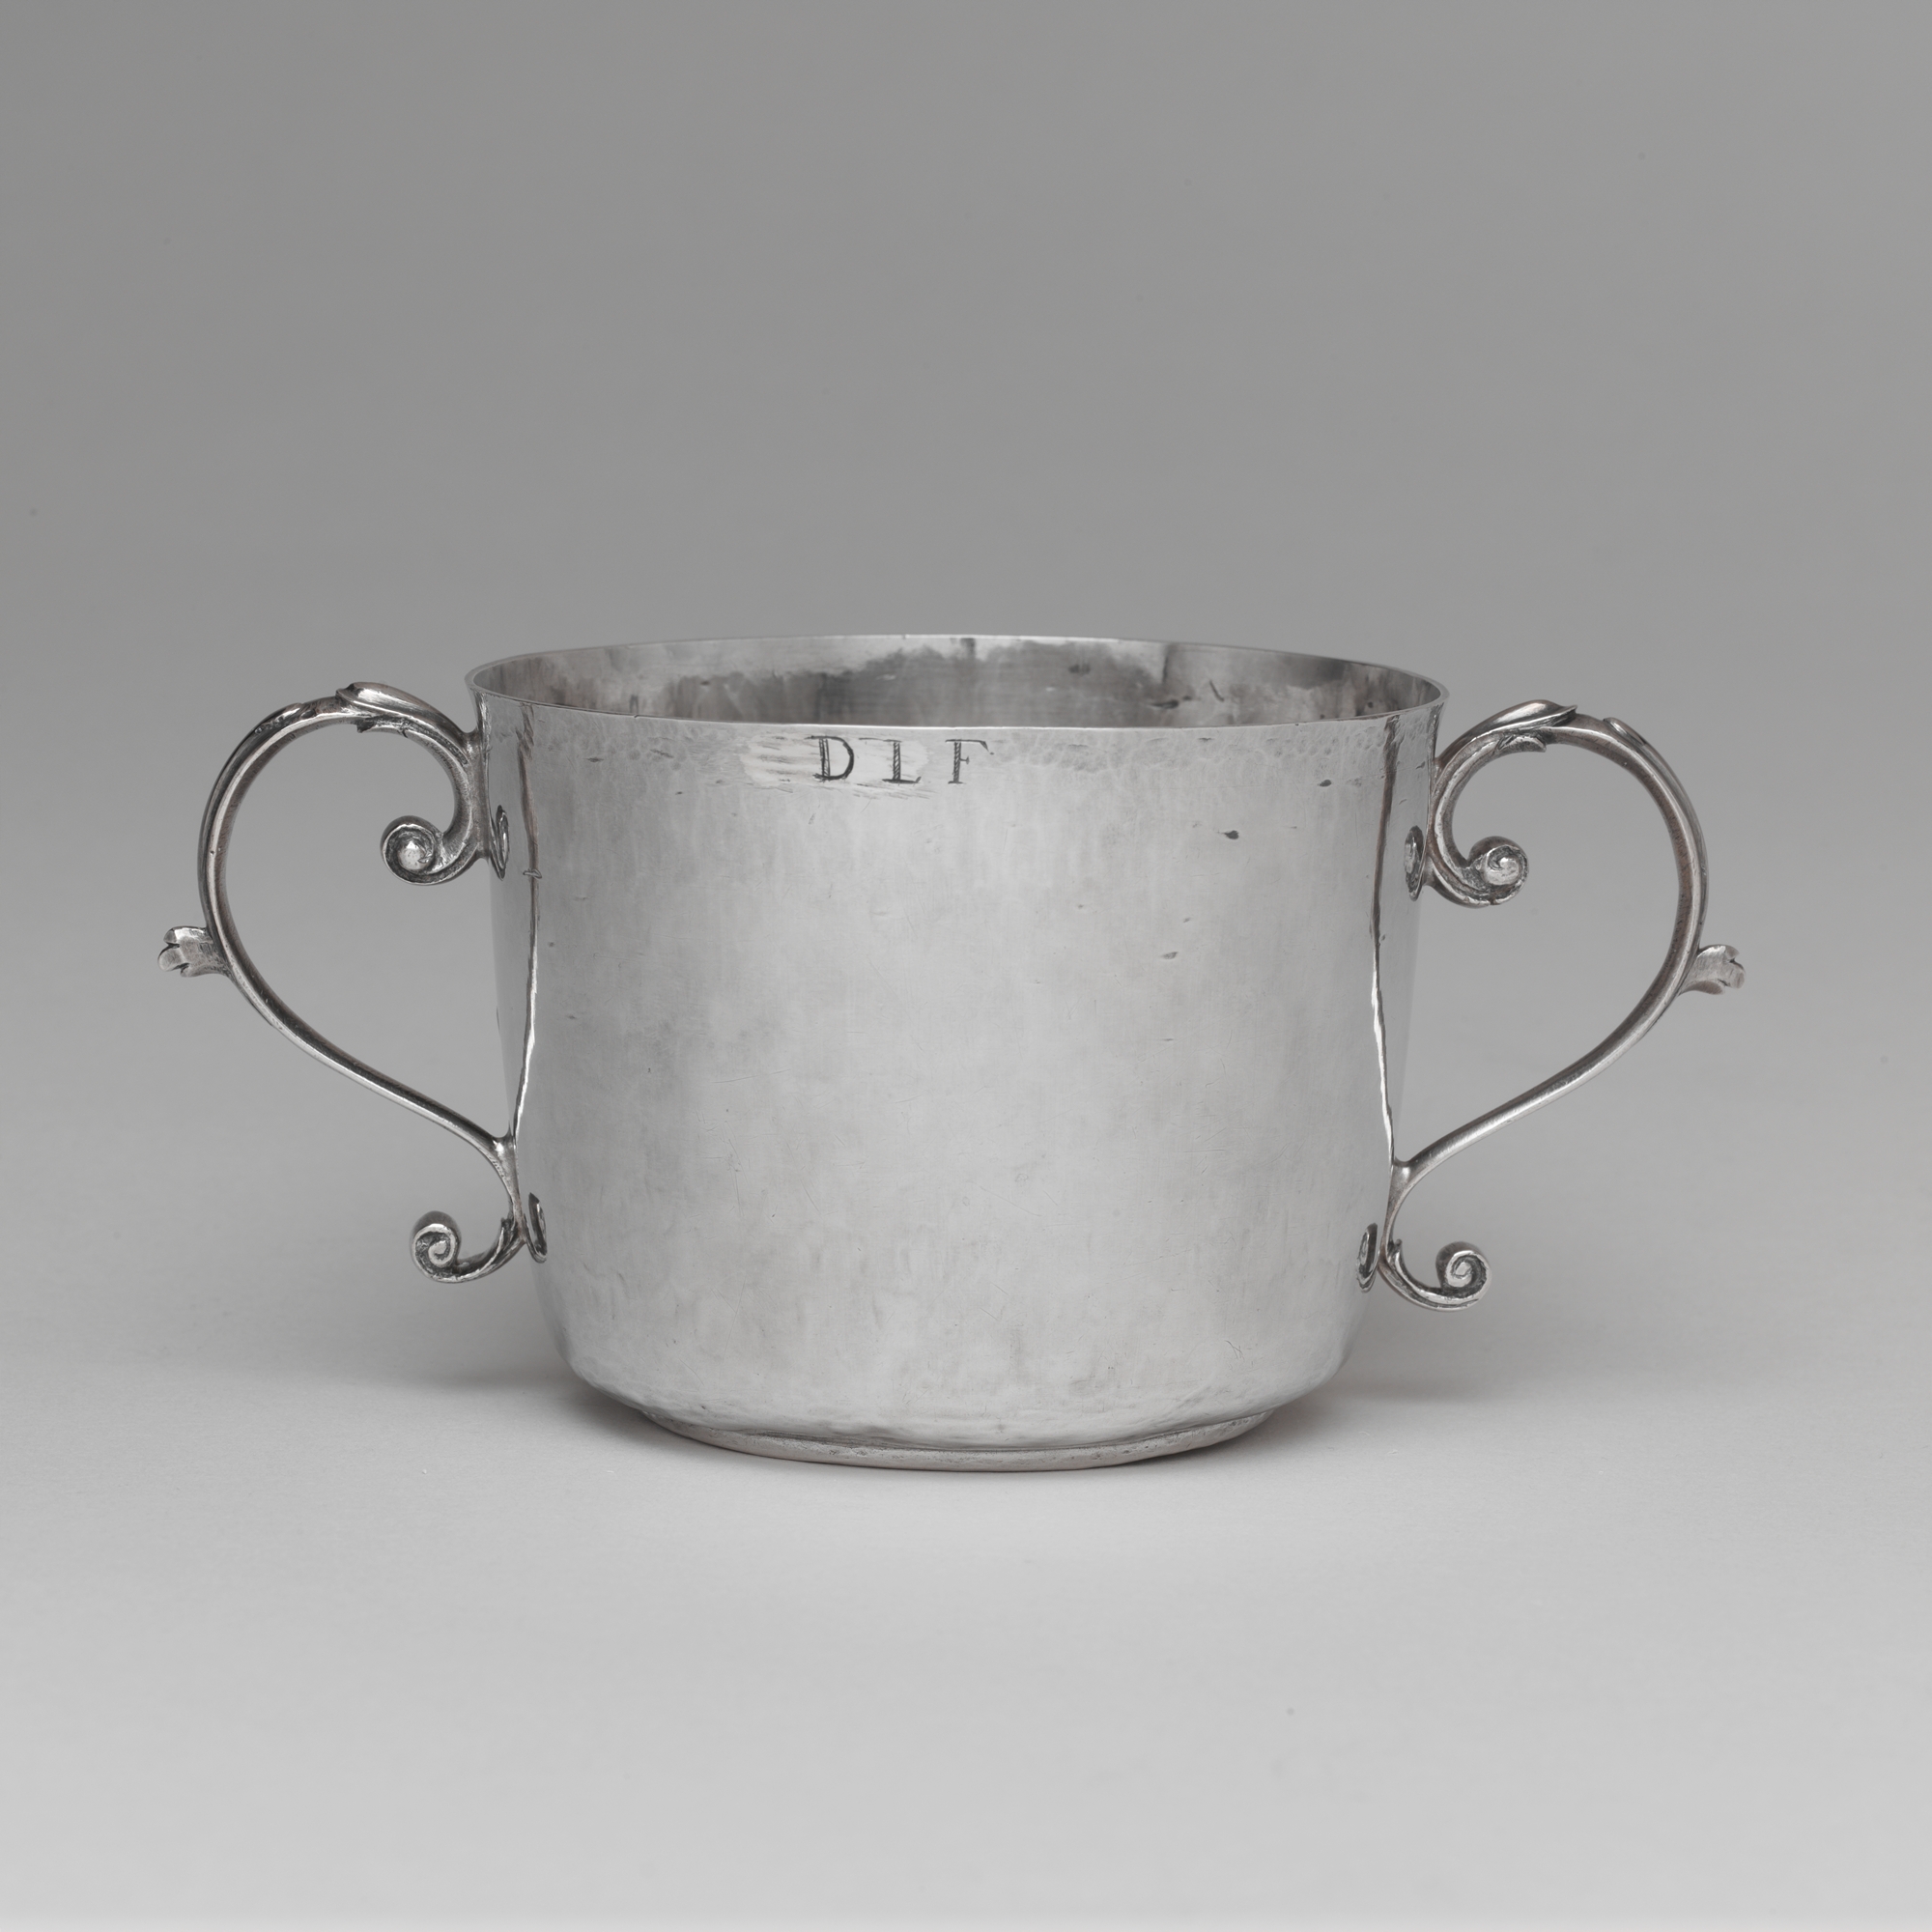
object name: cup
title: Two-handled Cup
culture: british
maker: joseph goldthwait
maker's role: former attribution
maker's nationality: american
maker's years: 1706-1780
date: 1730-1745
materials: silver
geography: united states